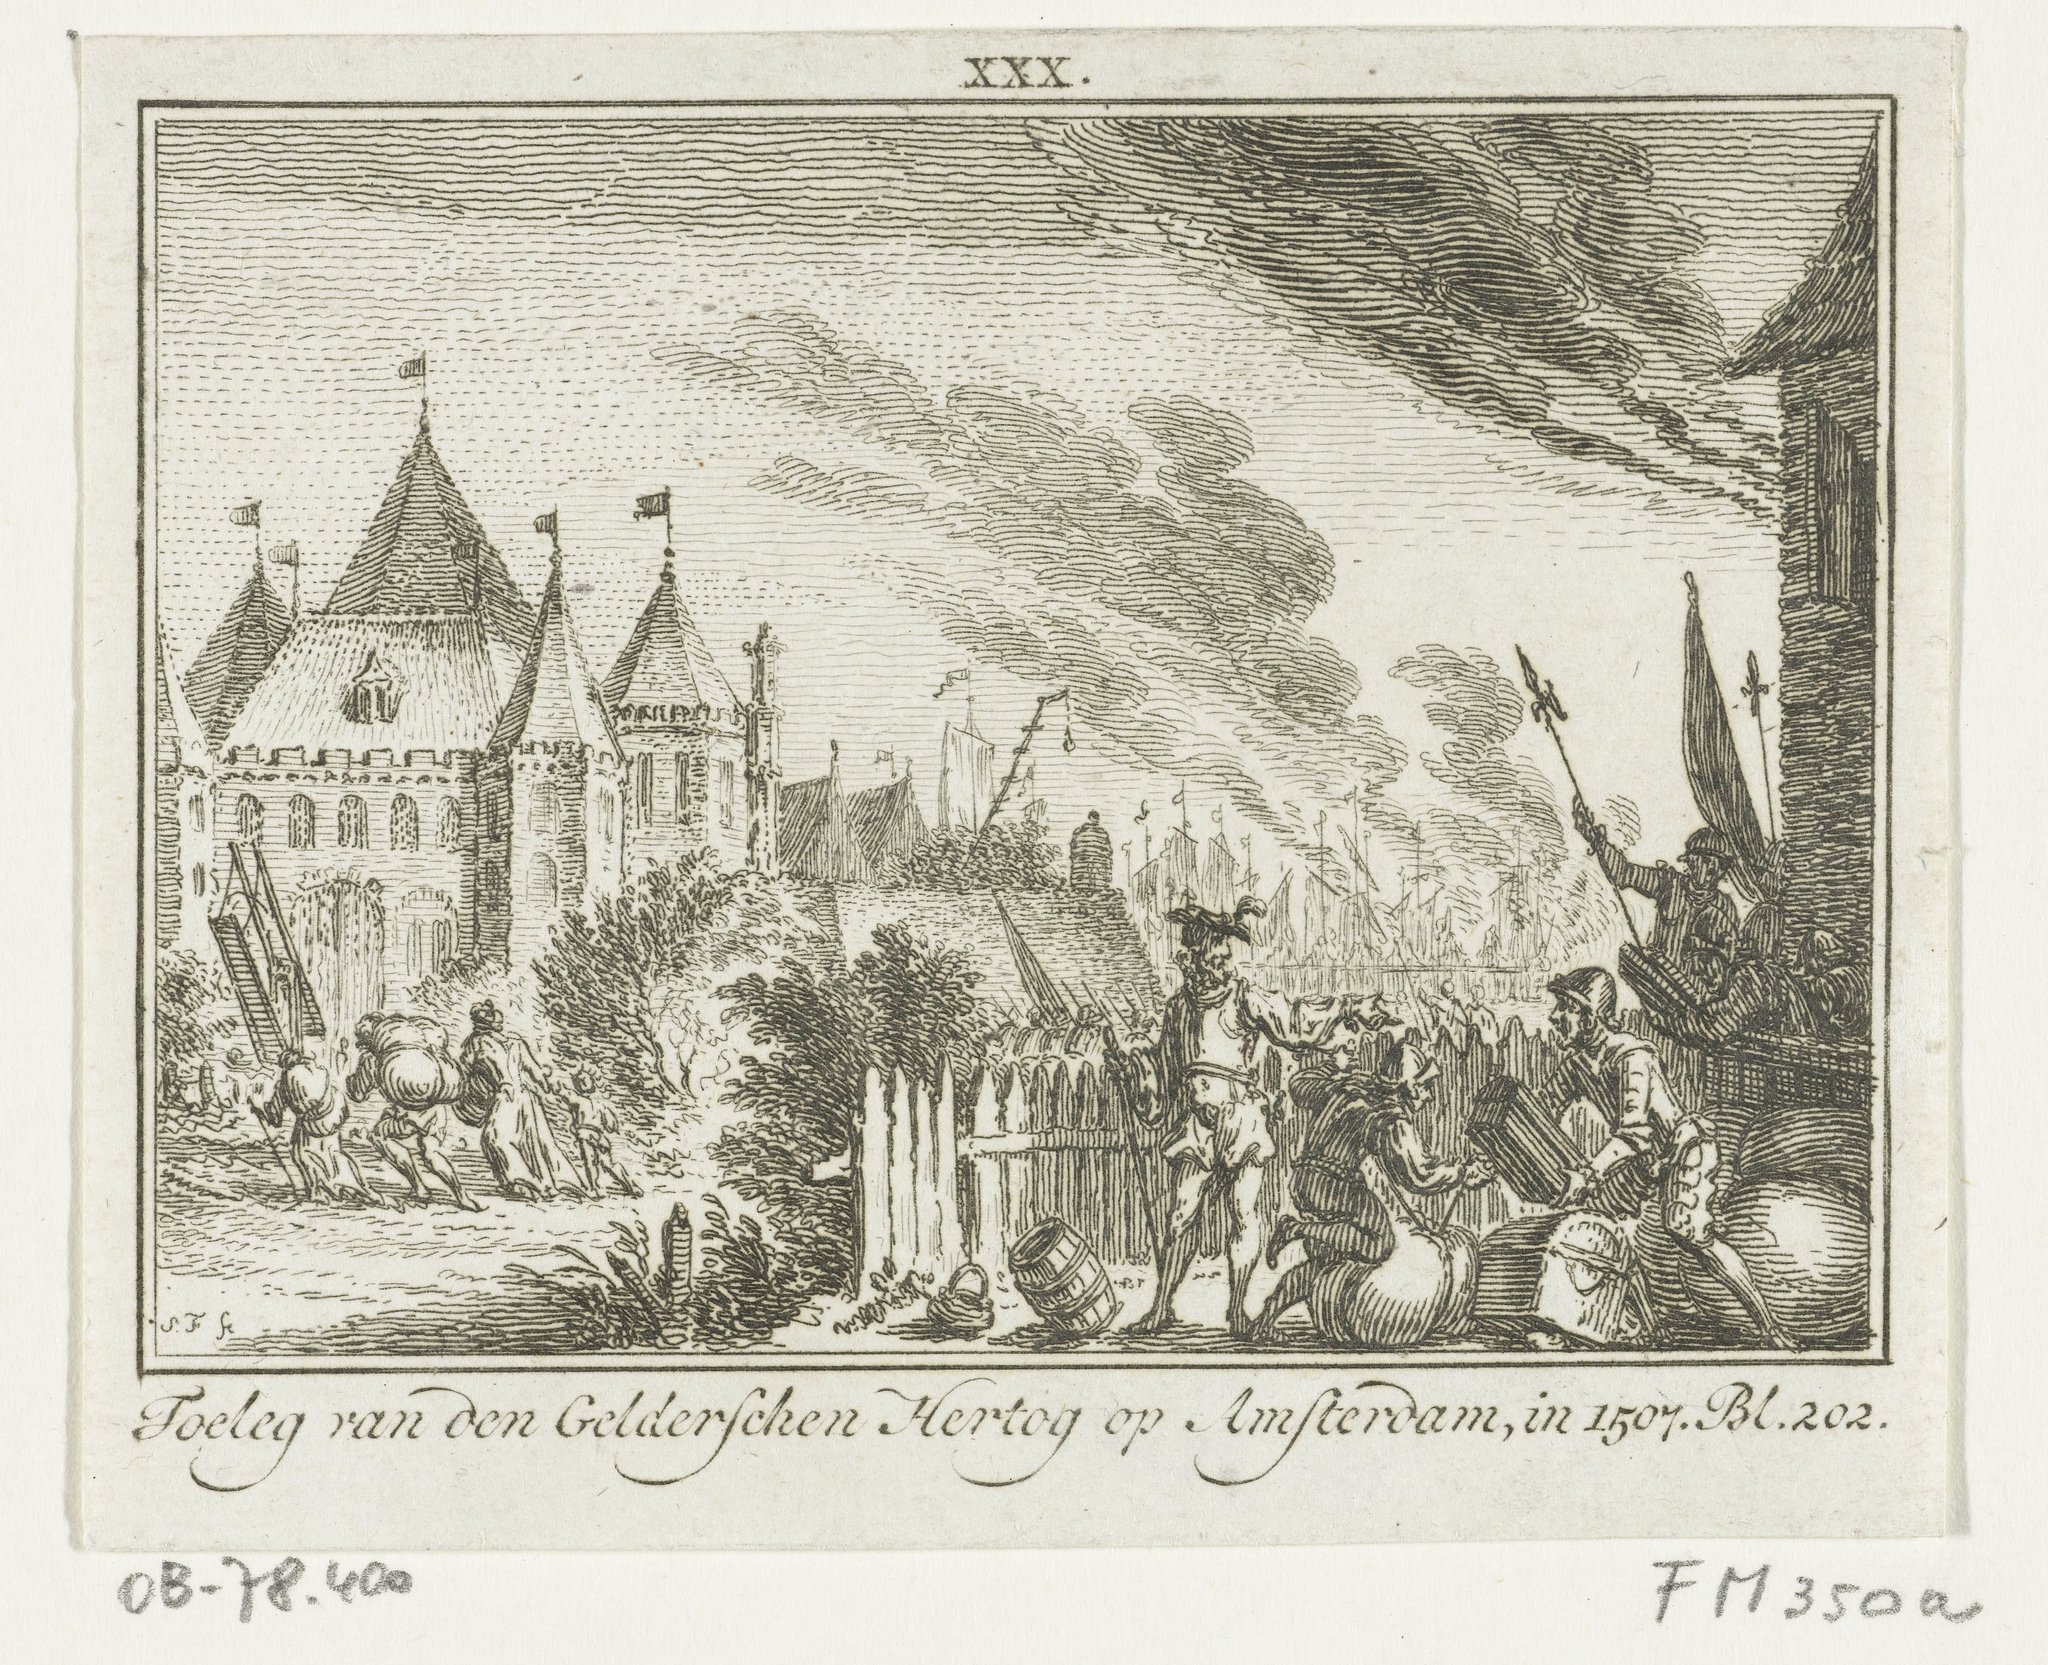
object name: print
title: Toeleg van den Gelderschen Hertog op Amsterdam, in 1507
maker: simon fokke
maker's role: draughtsman, print maker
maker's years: 1712-1784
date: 1782-1784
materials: paper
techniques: etching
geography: northern netherlands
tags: grave, arnhem, battle, fighting in general, amsterdam, guelders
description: Illustratie voor: J.W. te Water, De vaderlandsche Historie van den heere J. Wagenaar, verkort, en met leerzaame aanmerkingen, ten dienste der Nederlandsche jeugd, 1784-1800, 4 delen, p. 202, pl. XXX. Staat met de letter.